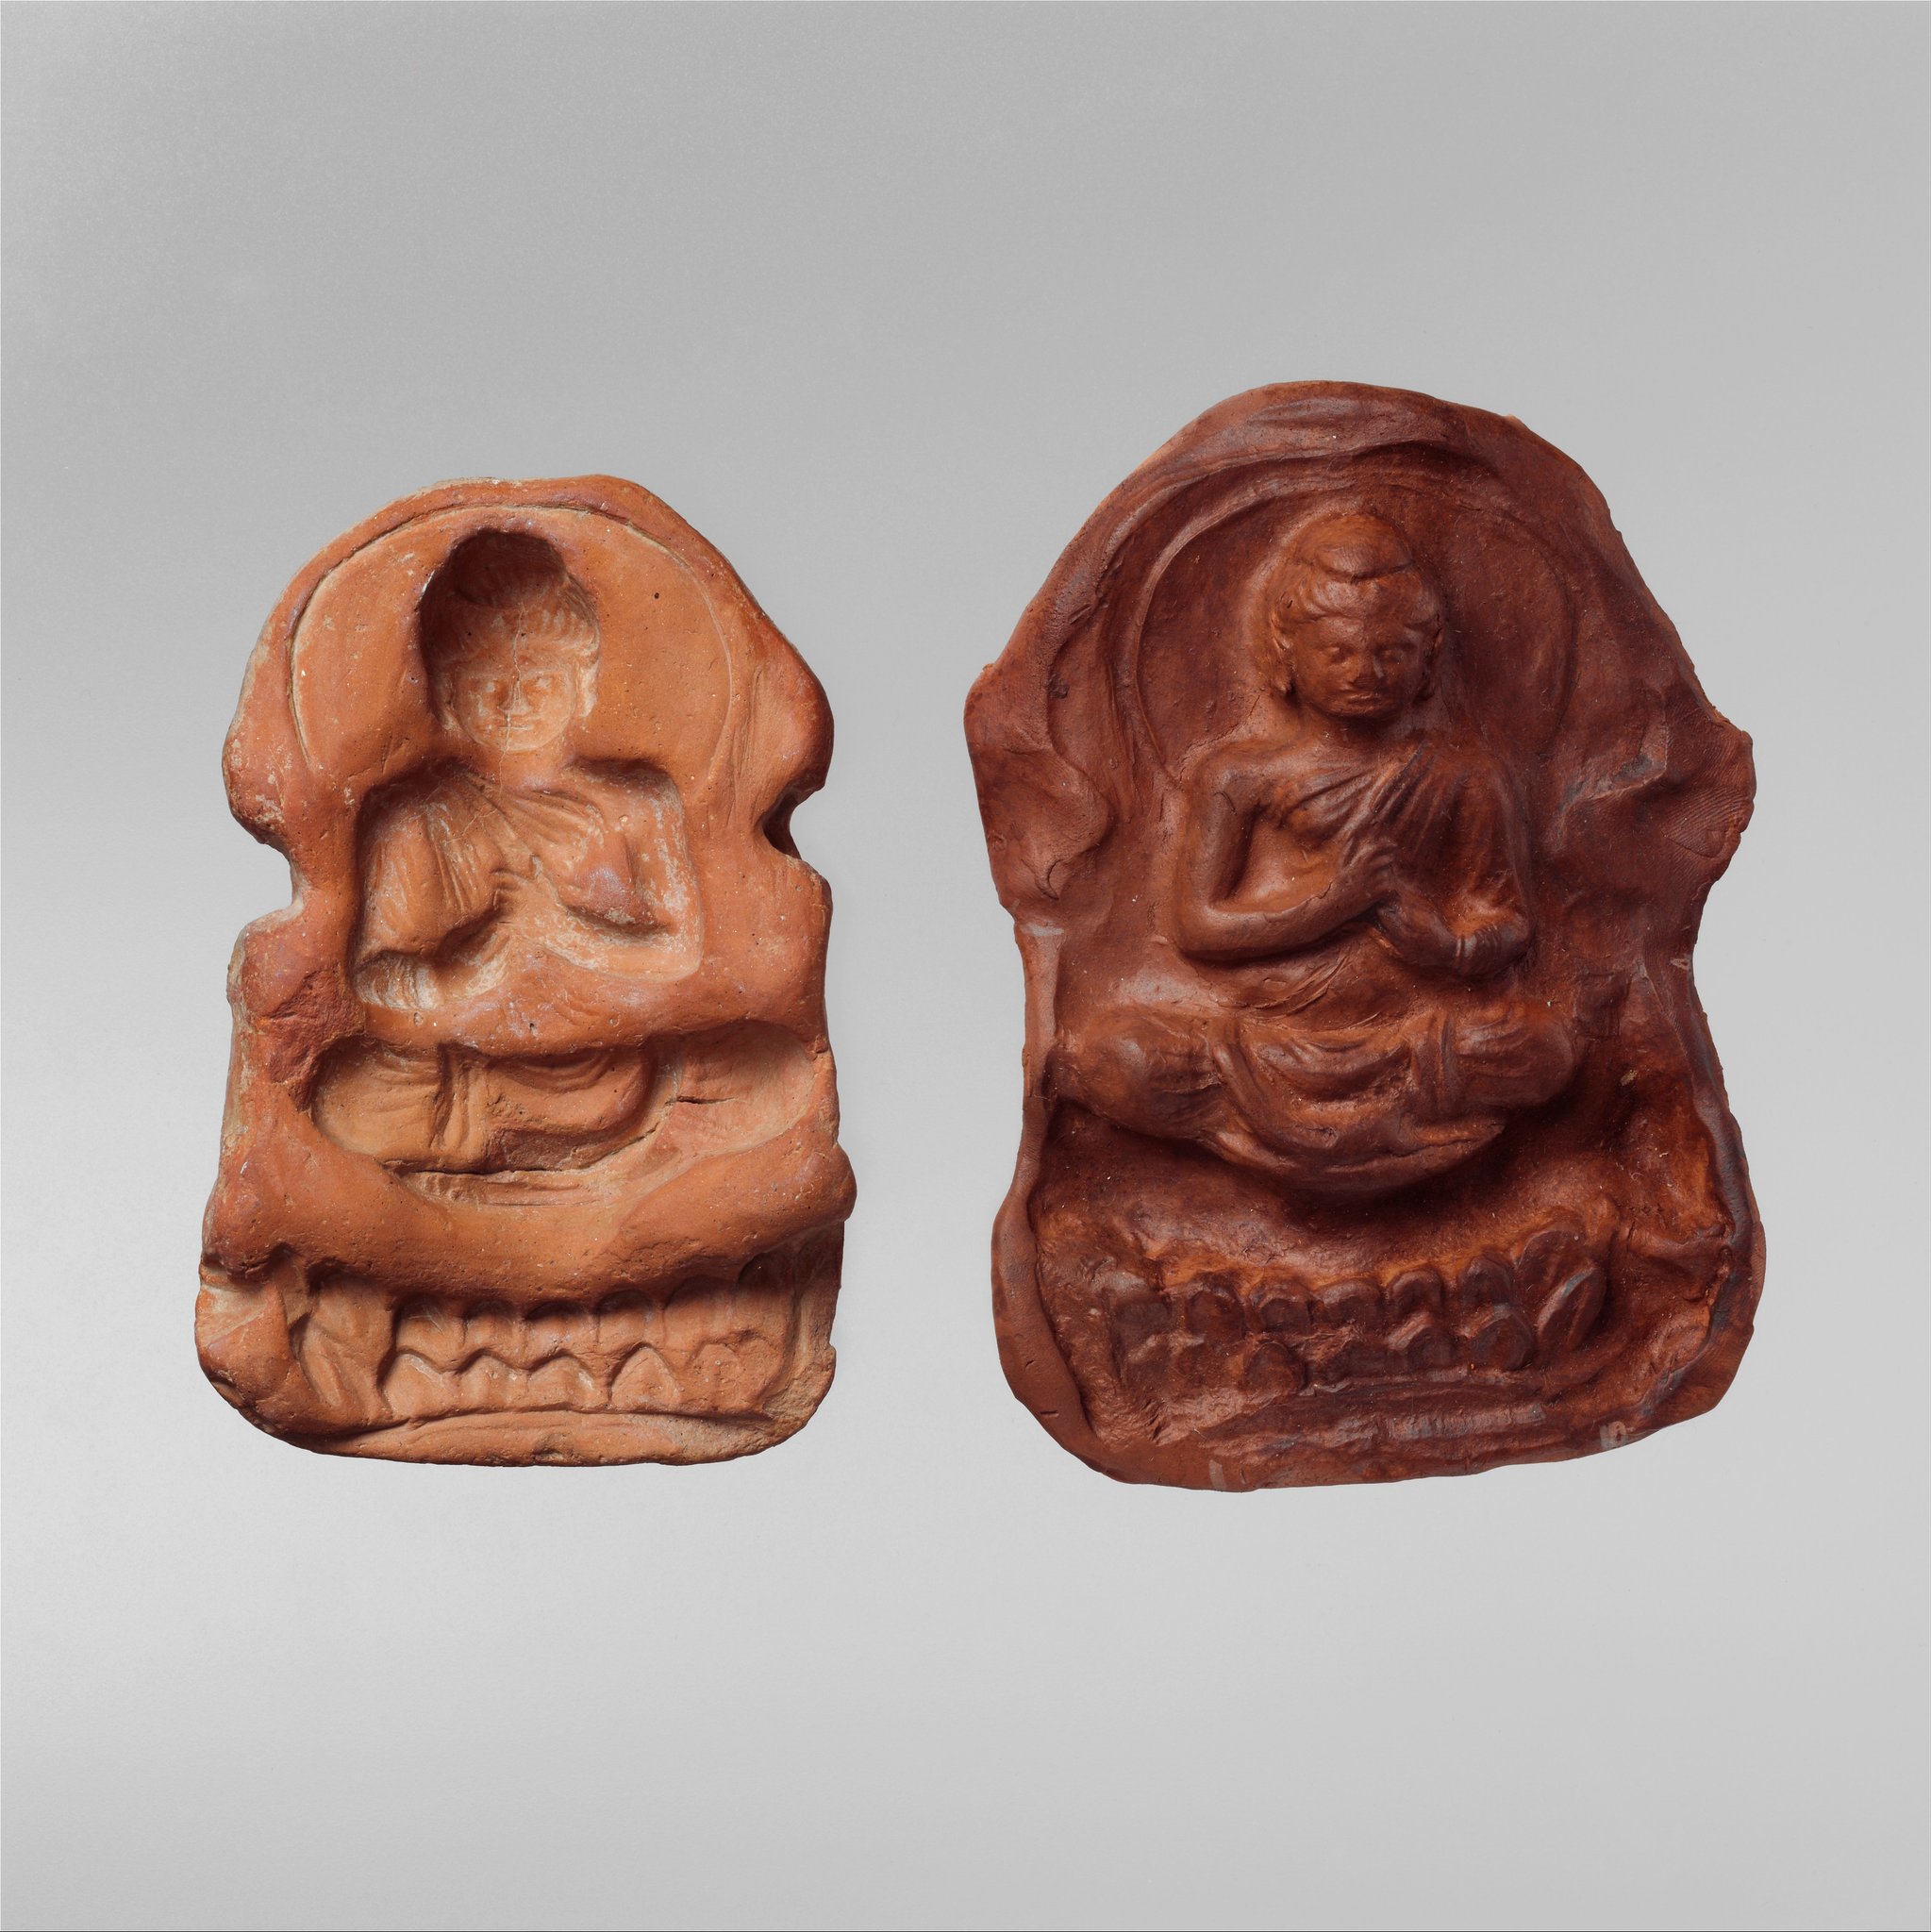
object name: mold and impression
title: Mold and Impression for a Seated Buddha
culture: gandhara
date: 401-700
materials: terracotta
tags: gandhara,buddhism,buddha